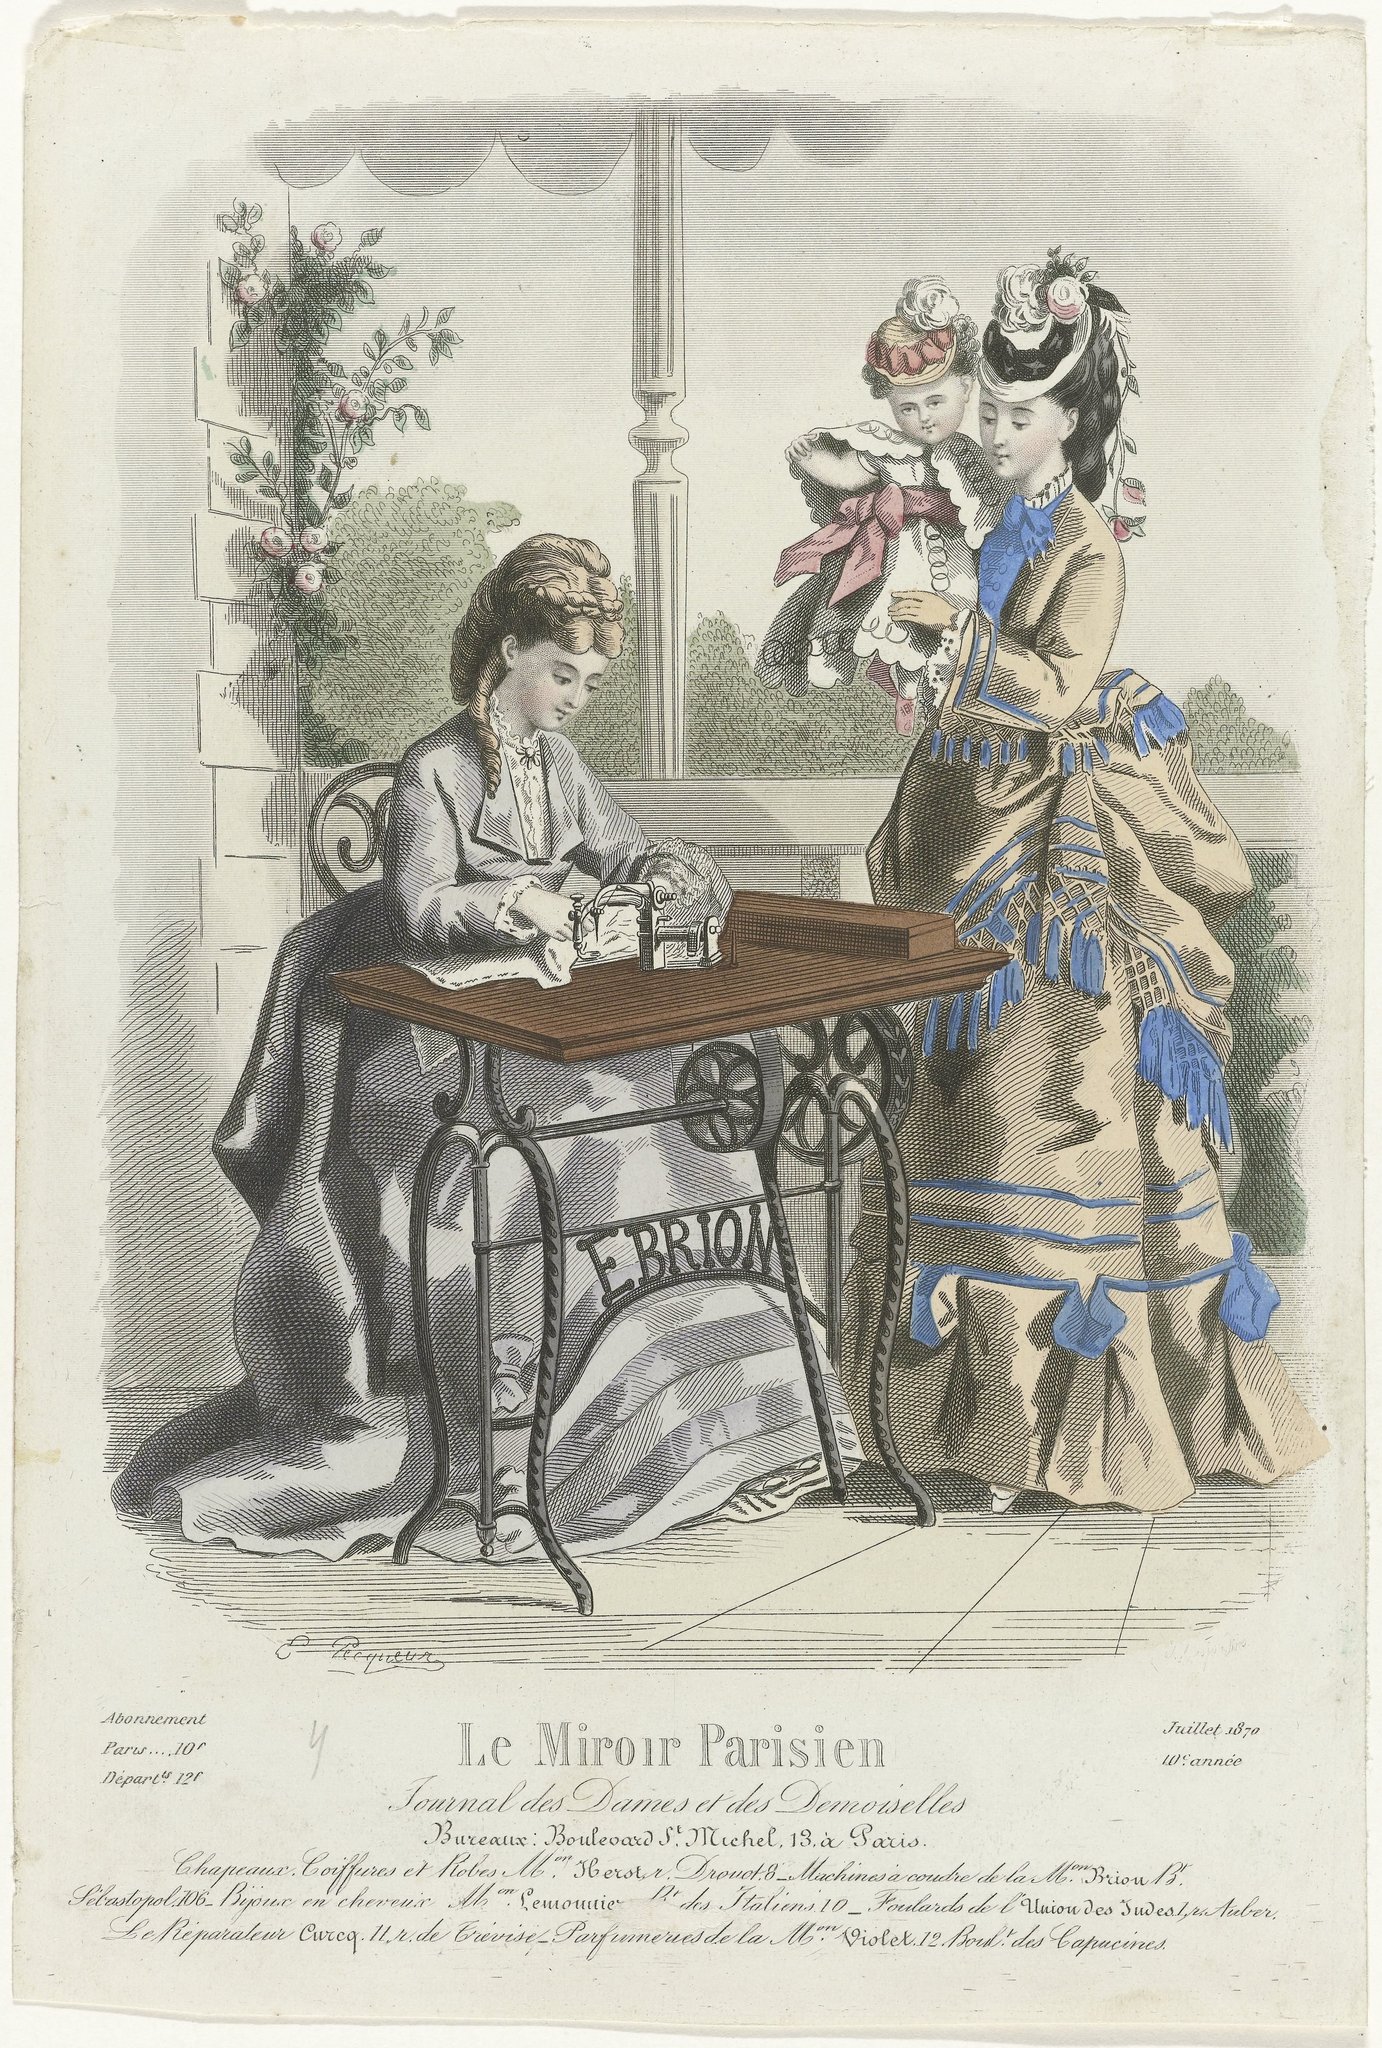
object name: fashion print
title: An Explosion of Fashion Magazines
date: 1870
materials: paper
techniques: engraving, hand coloring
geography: paris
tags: carrying a child on the hip, astride, head-gear (+ girls' clothes), sewing machine (+ sewing ~ home making of clothes), head-gear (+ women's clothes), styles of hairdress - aa - ~ women, fashion plates, dress, gown (+ women's clothes), neck-gear ~ clothing (+ women's clothes), dress, gown (+ girls' clothes)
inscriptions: title: ‘Le Miroir Parisien / Journal des Dames et des Demoiselles’, inscription: ‘Abonnement Paris ....10f Départ.ts 12f’, caption: ‘Chapeaux. Coiffures et Robes M.on Herst.r. Drouot. 8 _ Machines à coudre de la M.on Brion Bt. Sébastopol. 106 _ Bijoux en cheveux Mon Lemonnier Bt des Italiens 10_ Foulards de l'Union des Indes. r. Auber. Le Réparateur Curcq. 11.r. de Trévise _ Parfumeries de la Mon Violet.12. Boult des Capucines.’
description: Starting from the 1850s, fashion magazines became more affordable and acquired a wider readership. The invention of the sewing machine around 1850 made it easier for people to make their own clothes. Ready-made garments were now also on offer, with fashion plates providing vendor addresses, such as the Maison Gagelin in Paris.